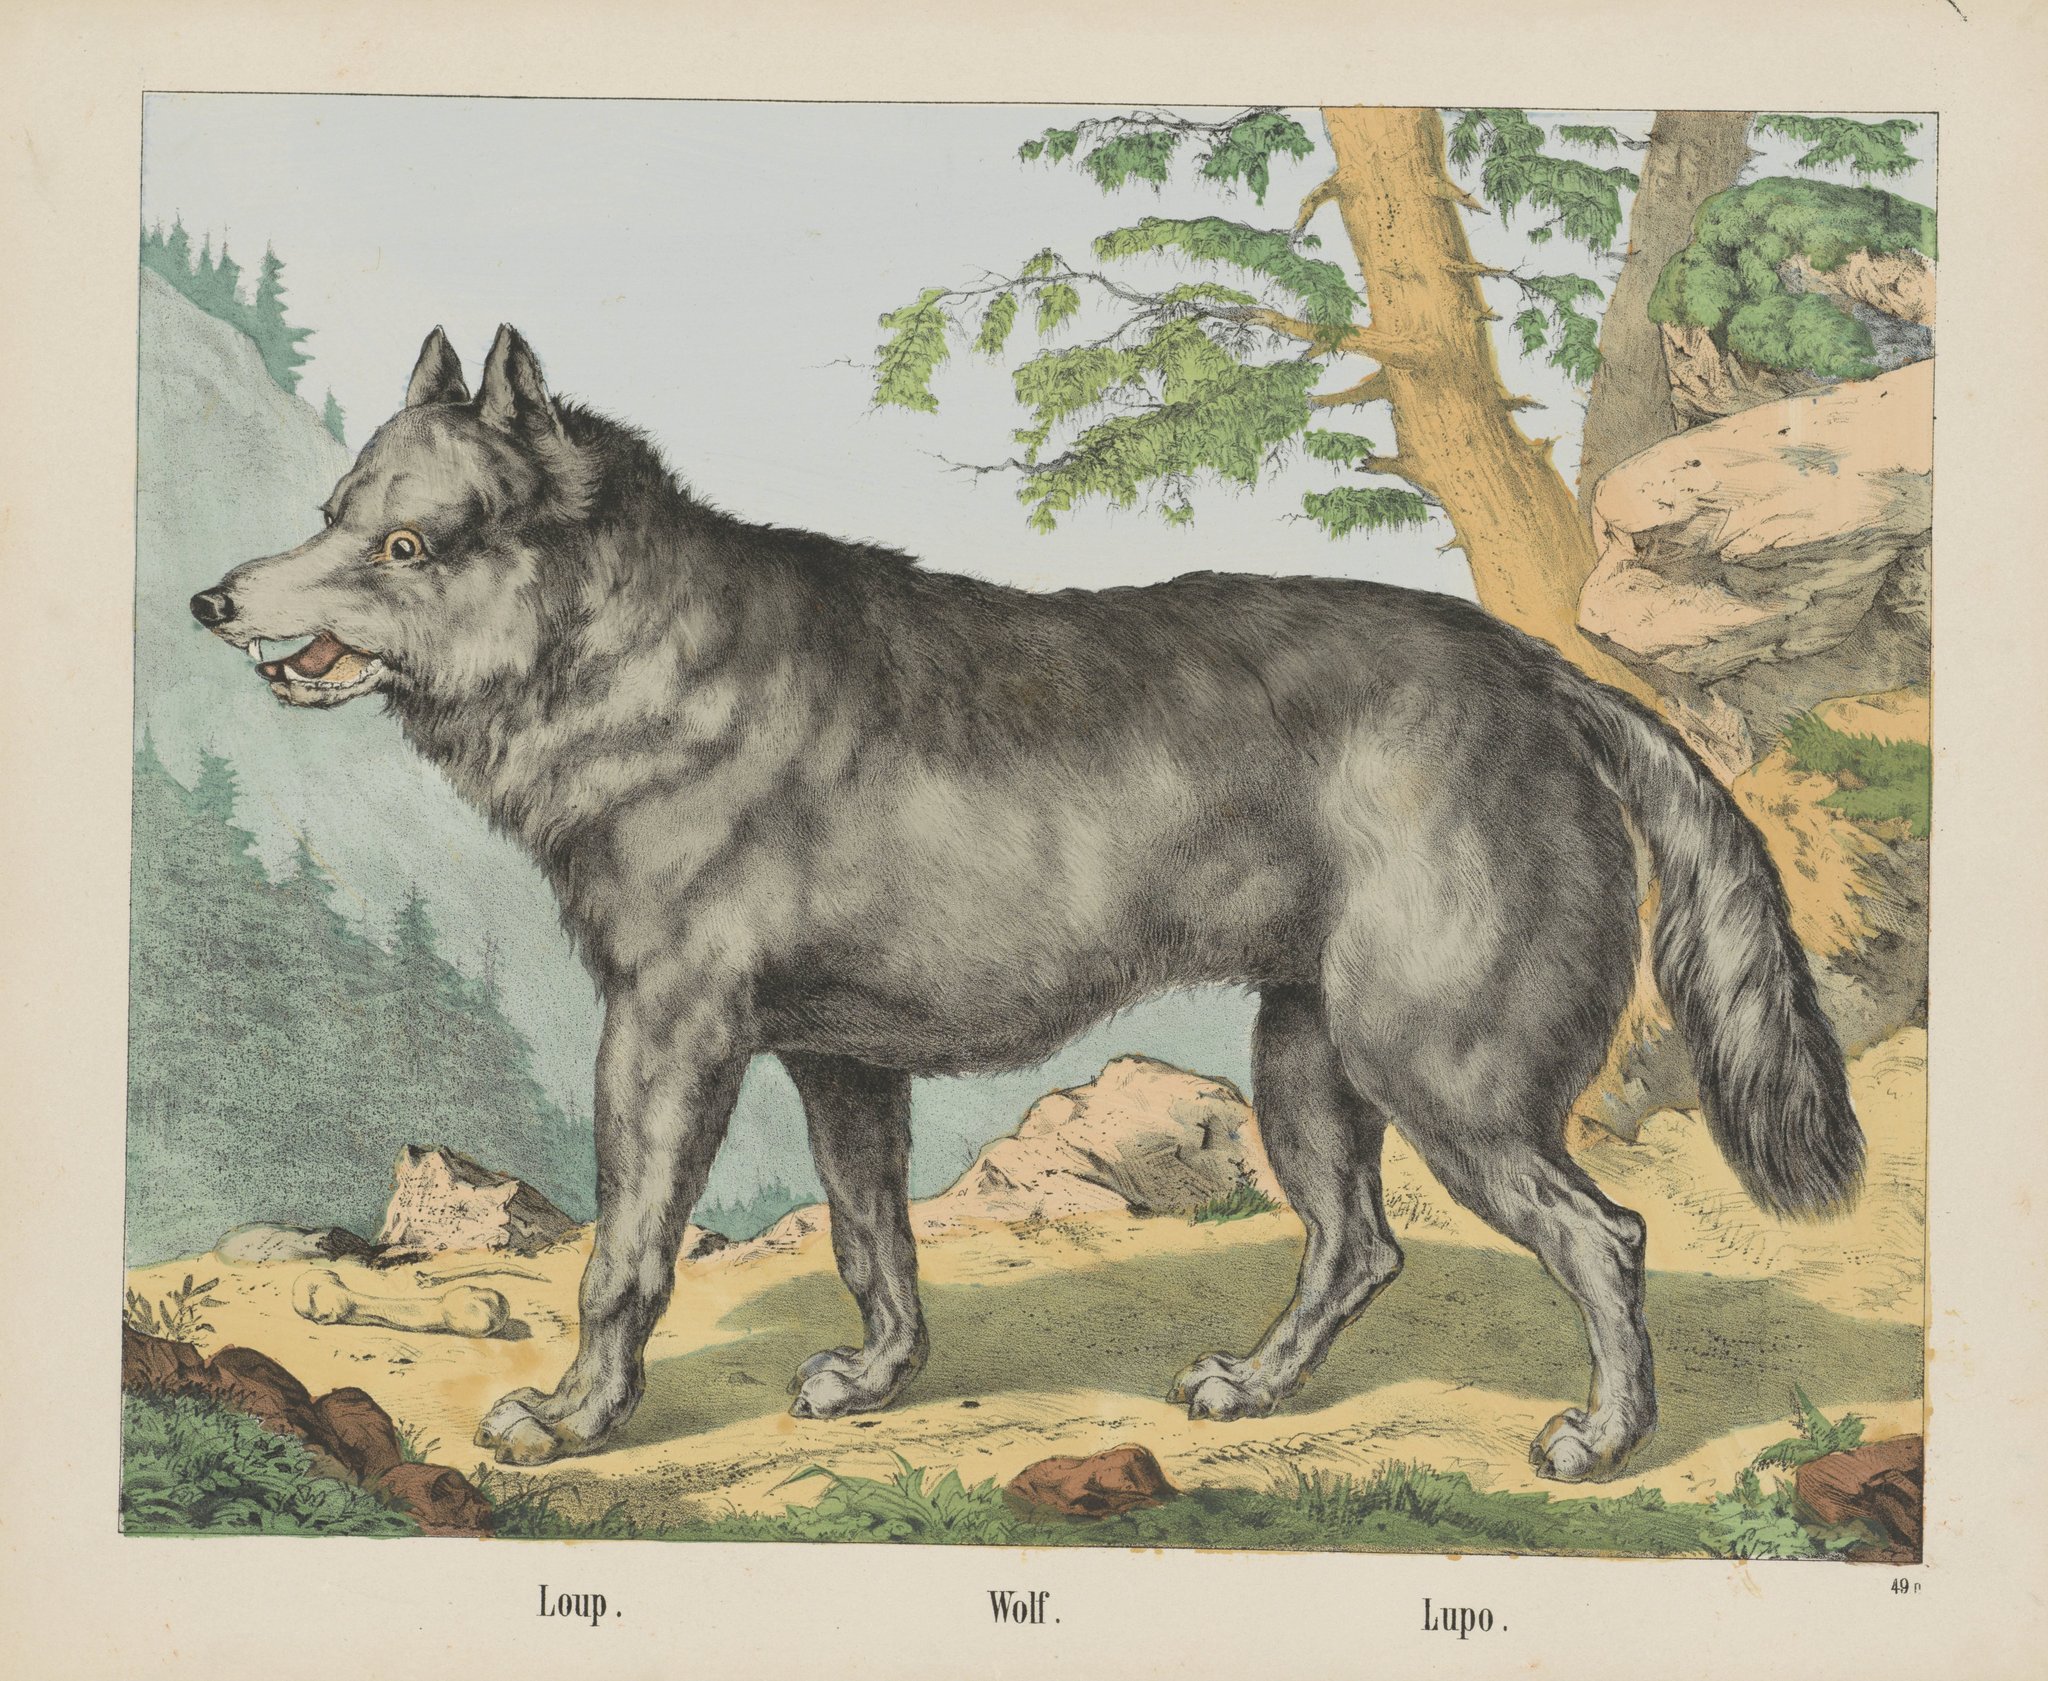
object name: popular print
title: Loup. / Wolf. / Lupo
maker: Anonymous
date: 1829-1880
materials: paper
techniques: colour, letterpress printing, lithograph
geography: mainz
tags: beasts of prey, predatory animals: wolf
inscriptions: collector's mark: Lugt 2760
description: Wolf in een heuvellandschap. Genummerd rechtsonder: No. 49n.